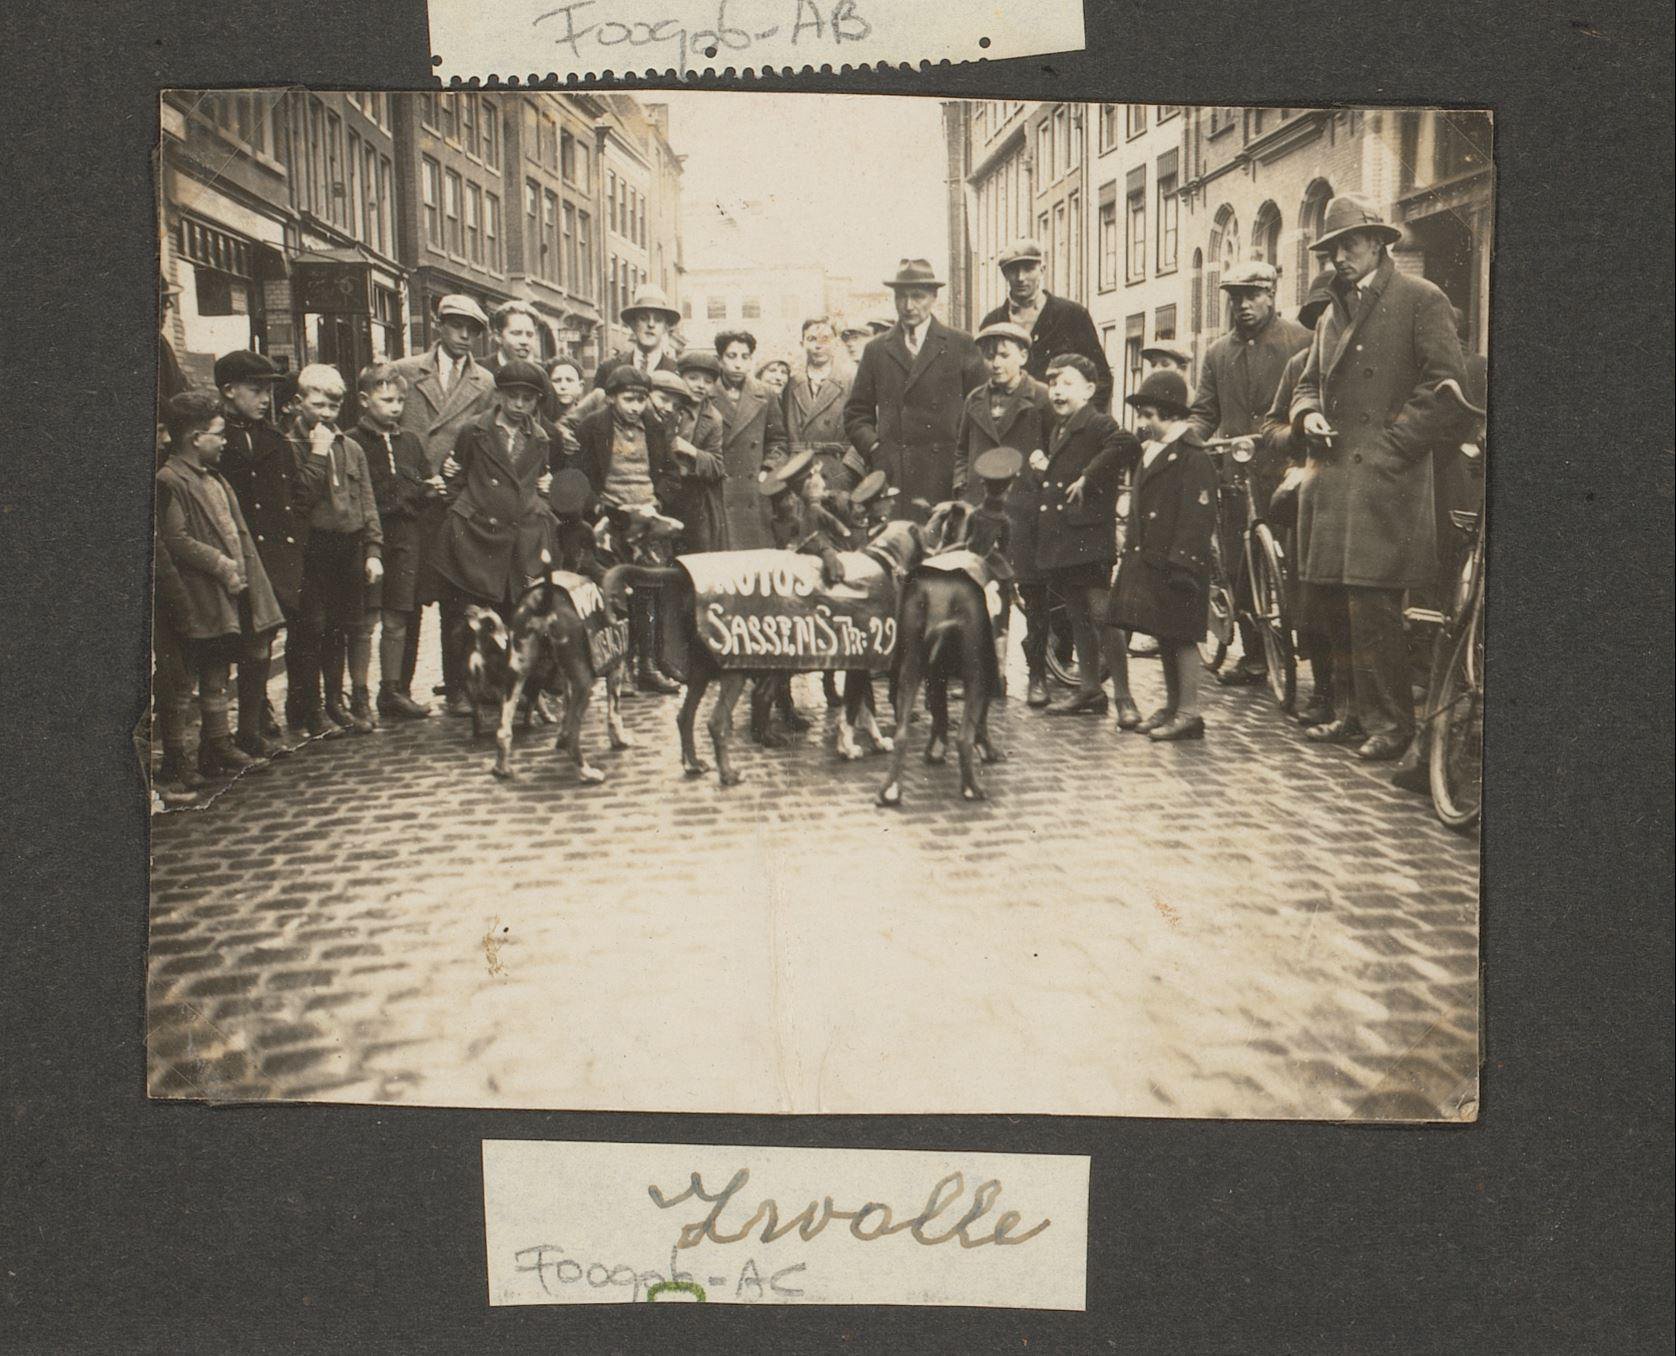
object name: album leaf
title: Honden met reclameteksten en publiek voor zaak in de Sassenstraat 29 te Zwolle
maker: Anonymous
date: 1930-1940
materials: photographic support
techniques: gelatin silver print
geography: zwolle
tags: advertising, street, dog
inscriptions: annotation: ‘Zwolle’